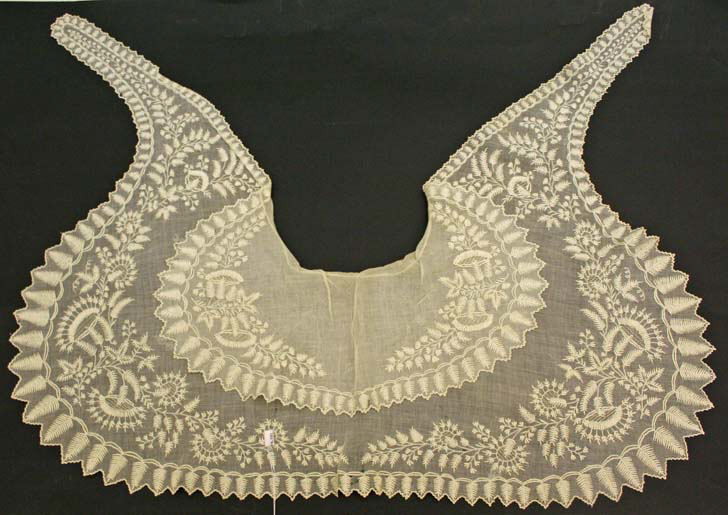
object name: collar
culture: american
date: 1830-1839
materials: linen